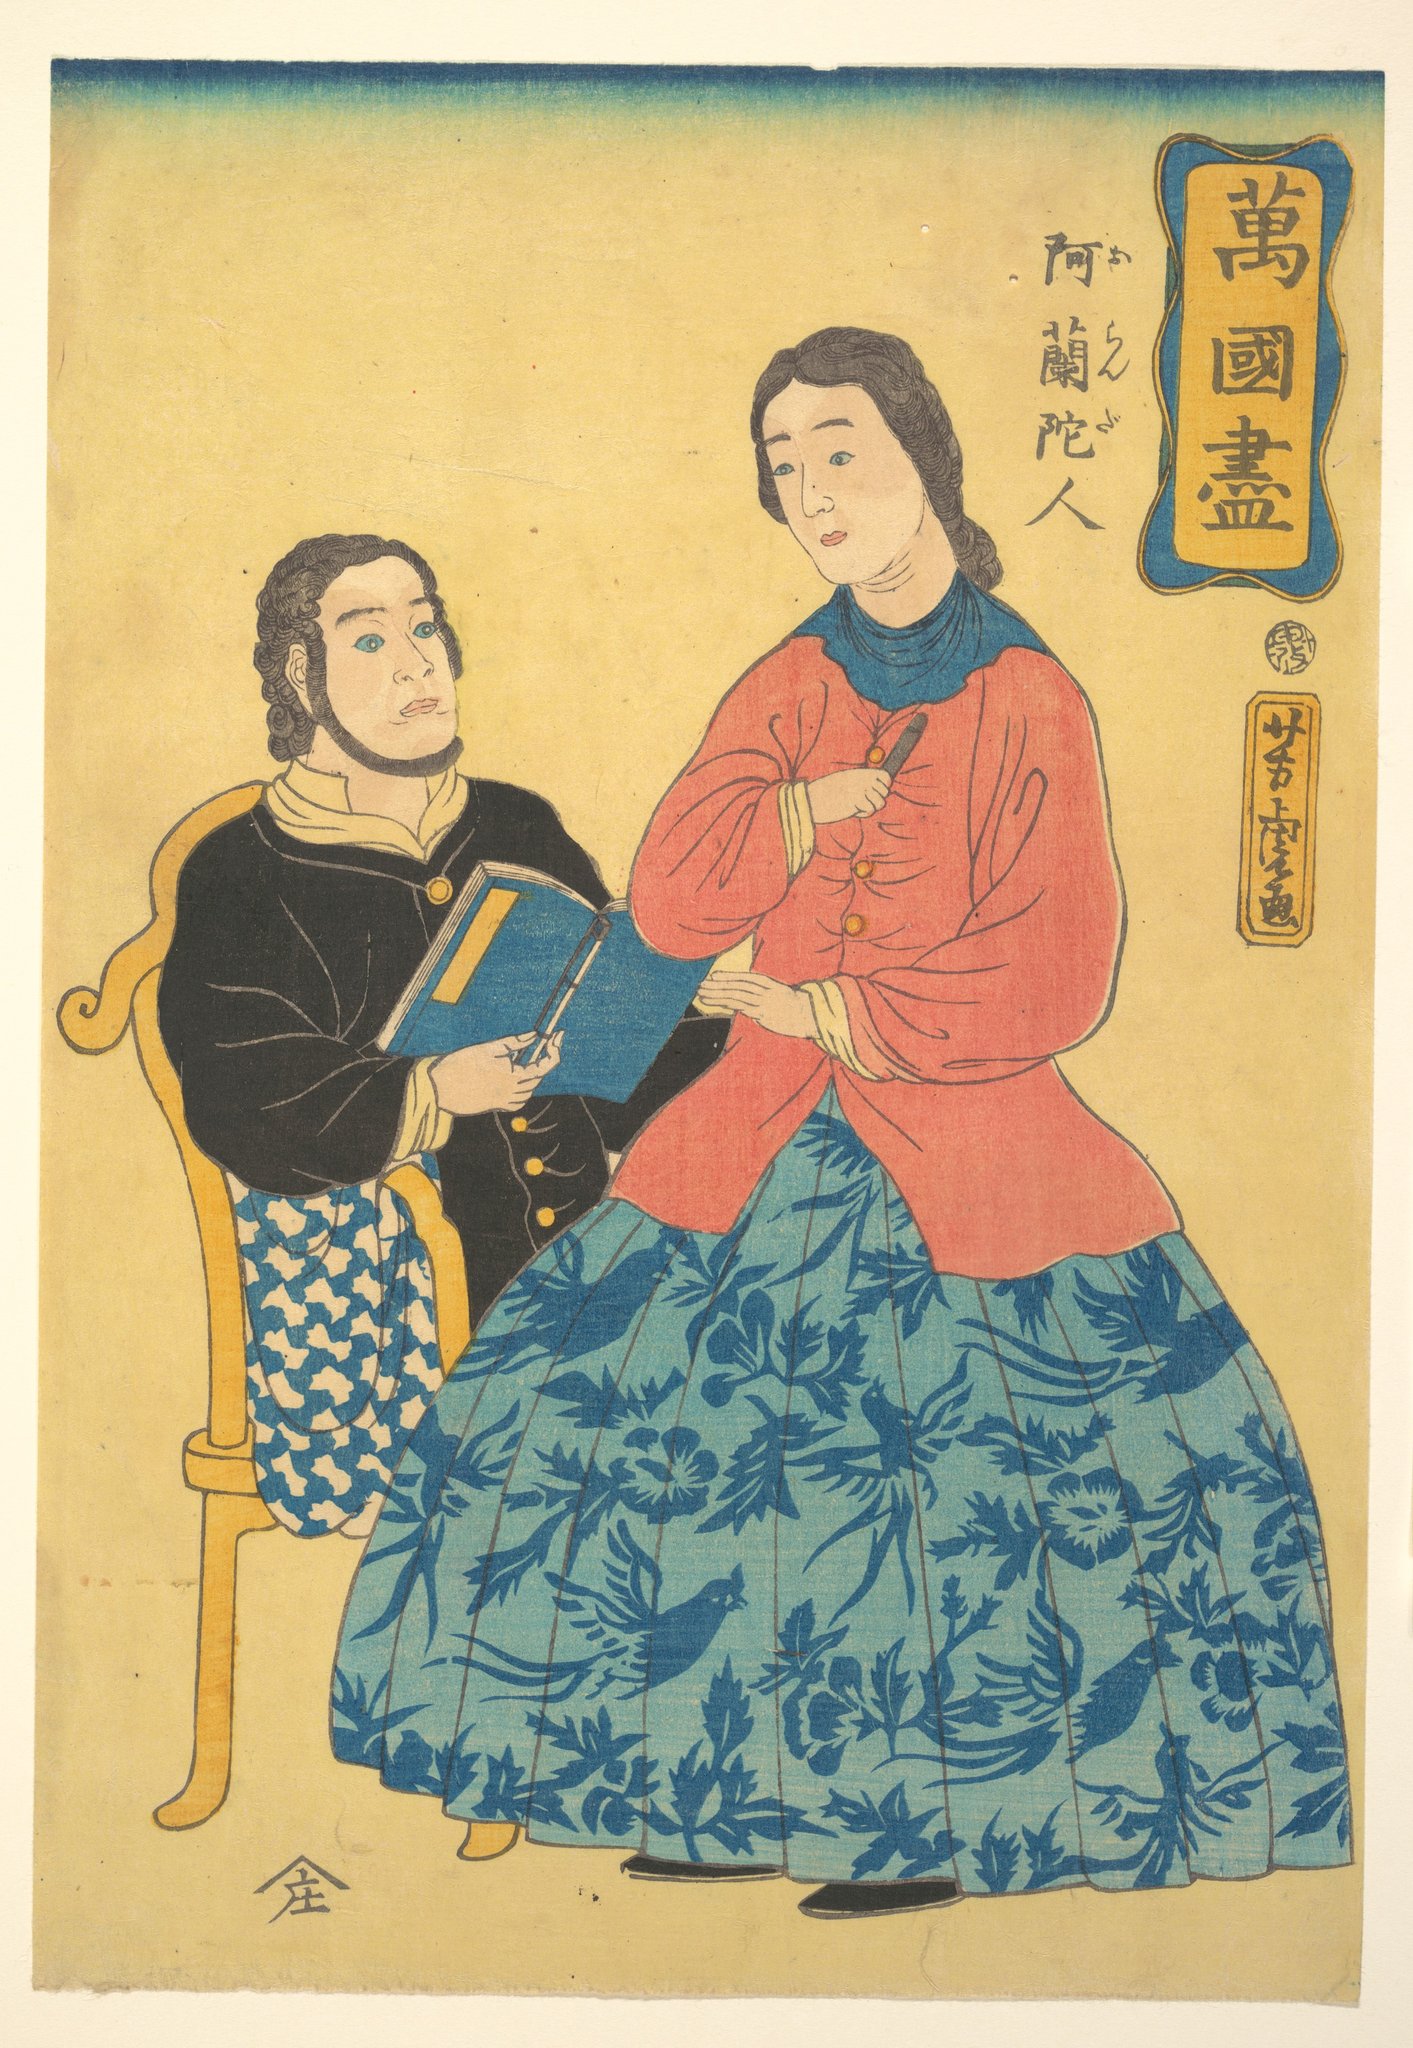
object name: print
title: Dutchmen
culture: japanese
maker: utagawa yoshitora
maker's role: artist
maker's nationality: japanese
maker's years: 1845-1880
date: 1860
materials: ink, paper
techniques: woodblock print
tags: men,women